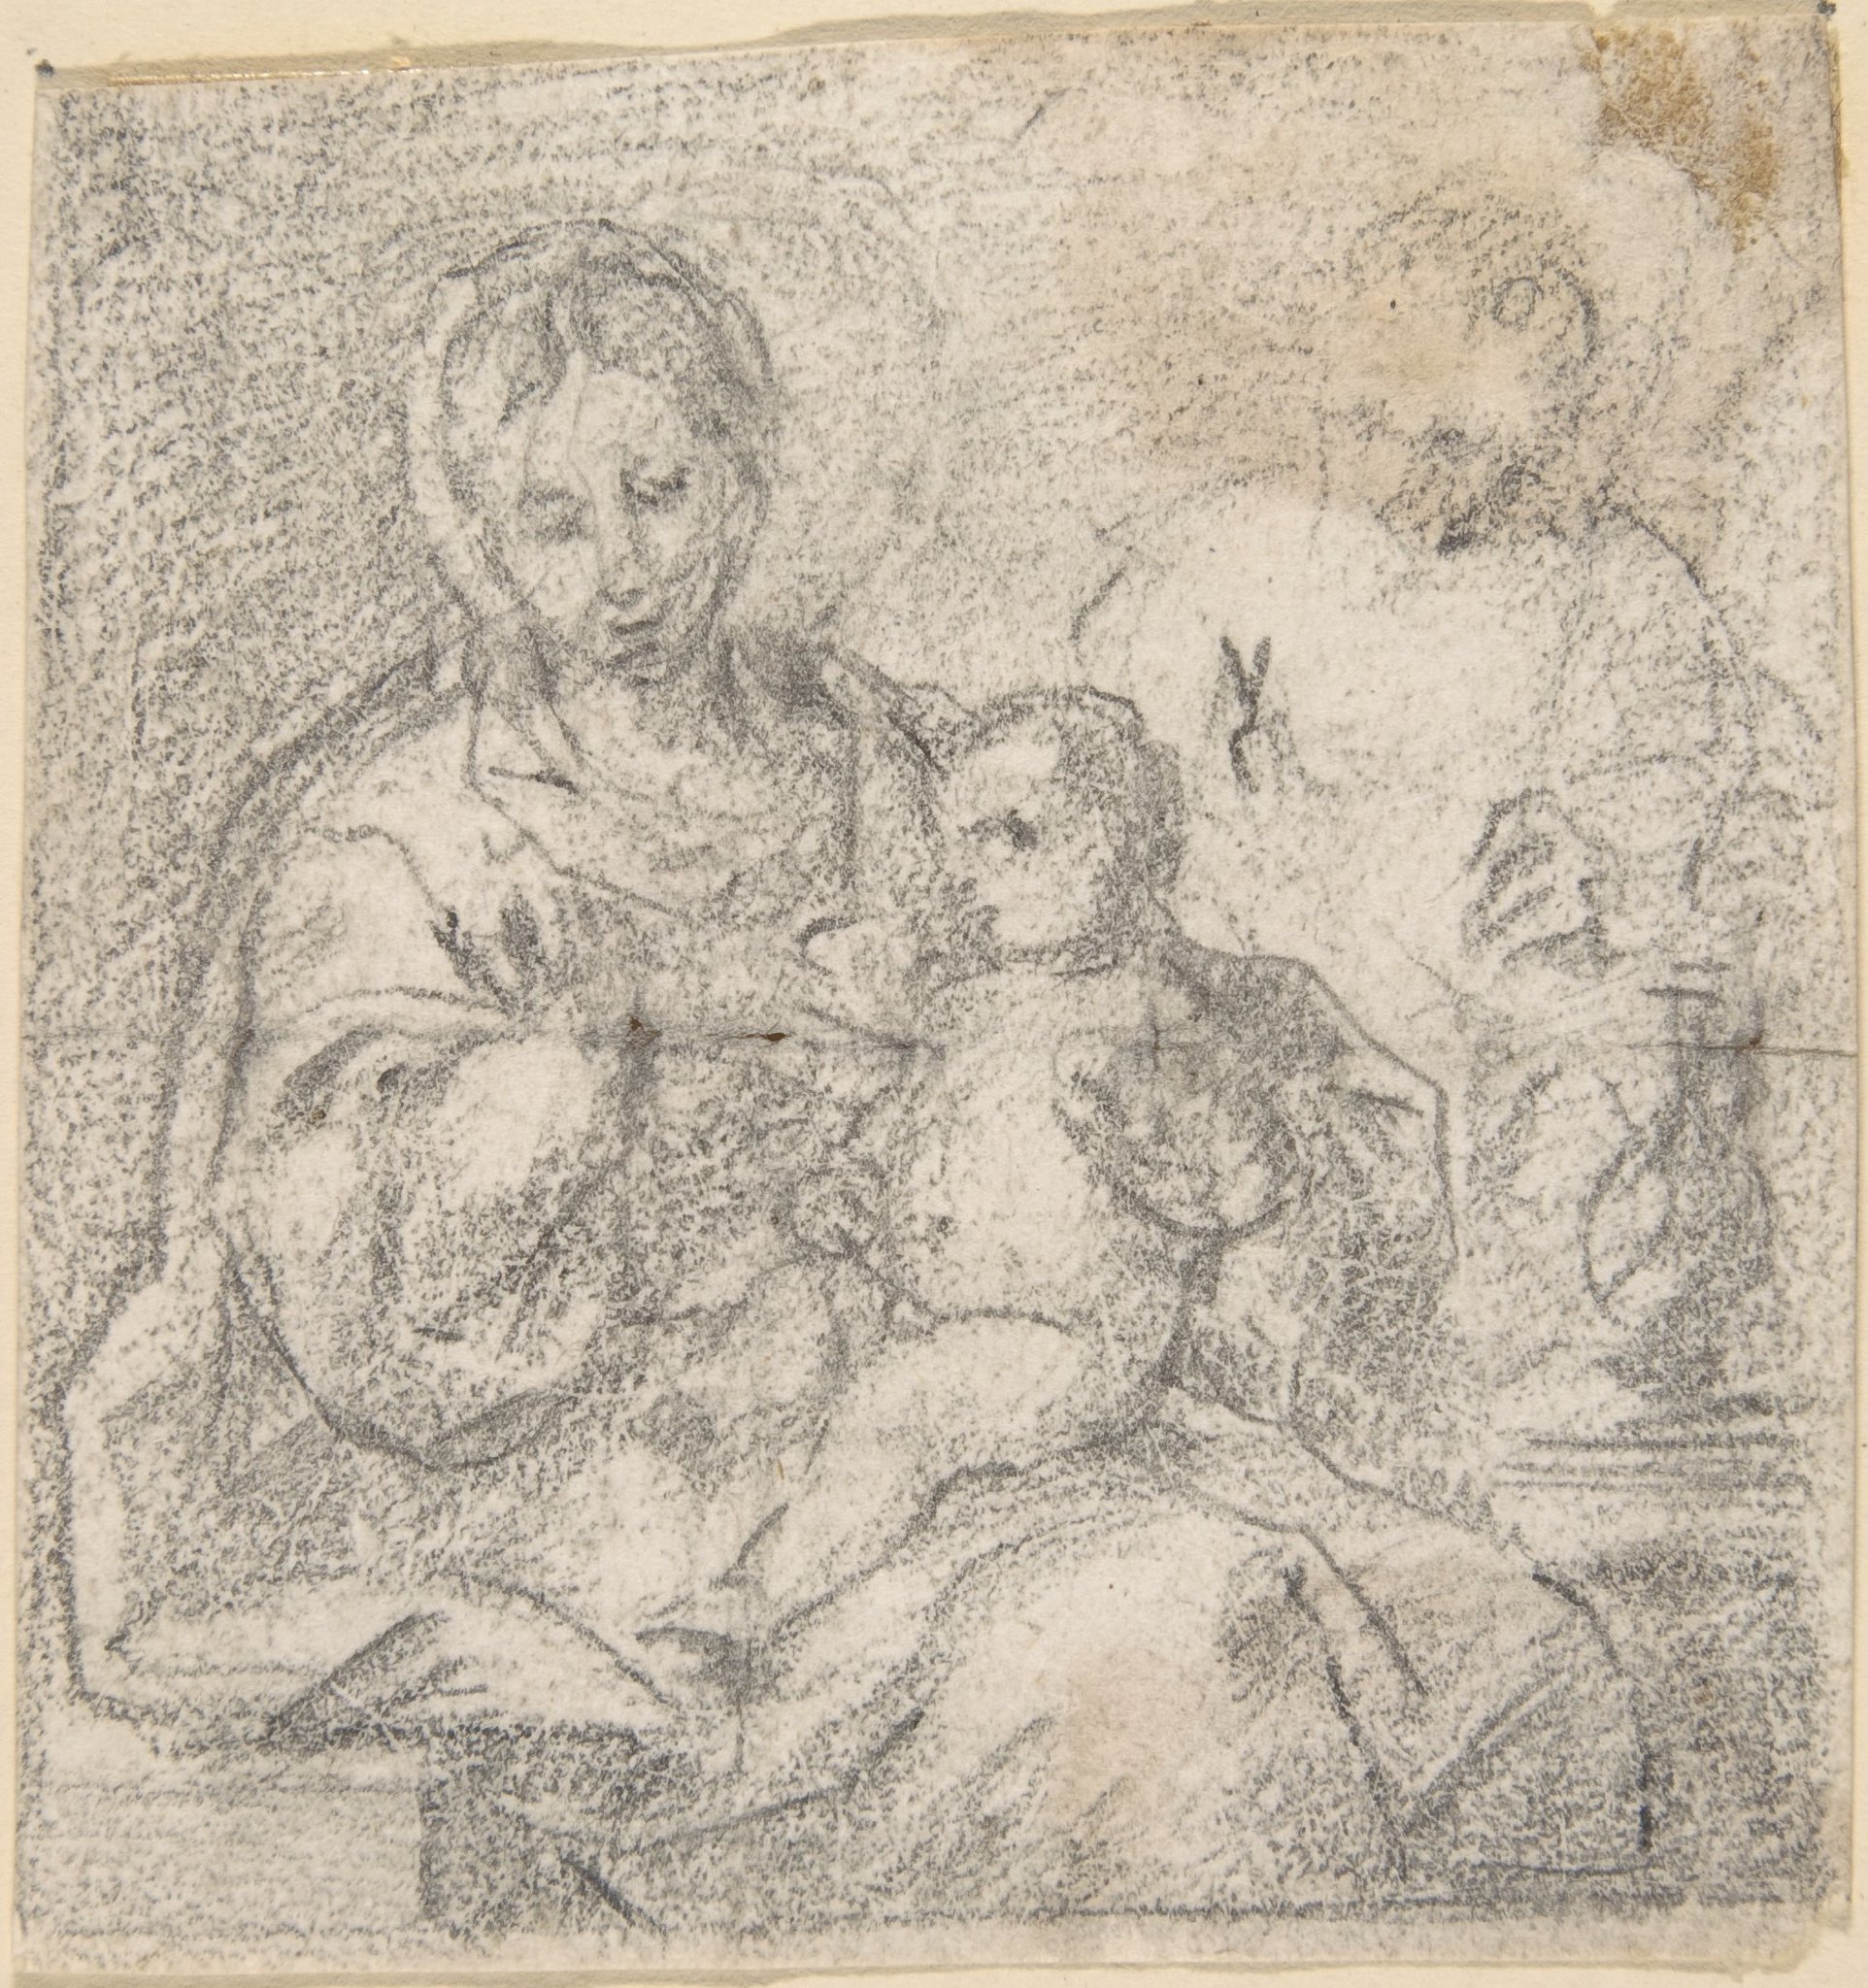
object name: drawing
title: Holy Family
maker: pedro duque cornejo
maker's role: artist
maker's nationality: spanish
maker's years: 1677-1757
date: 1700-1750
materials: chalk, paper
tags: infants,women,holy family